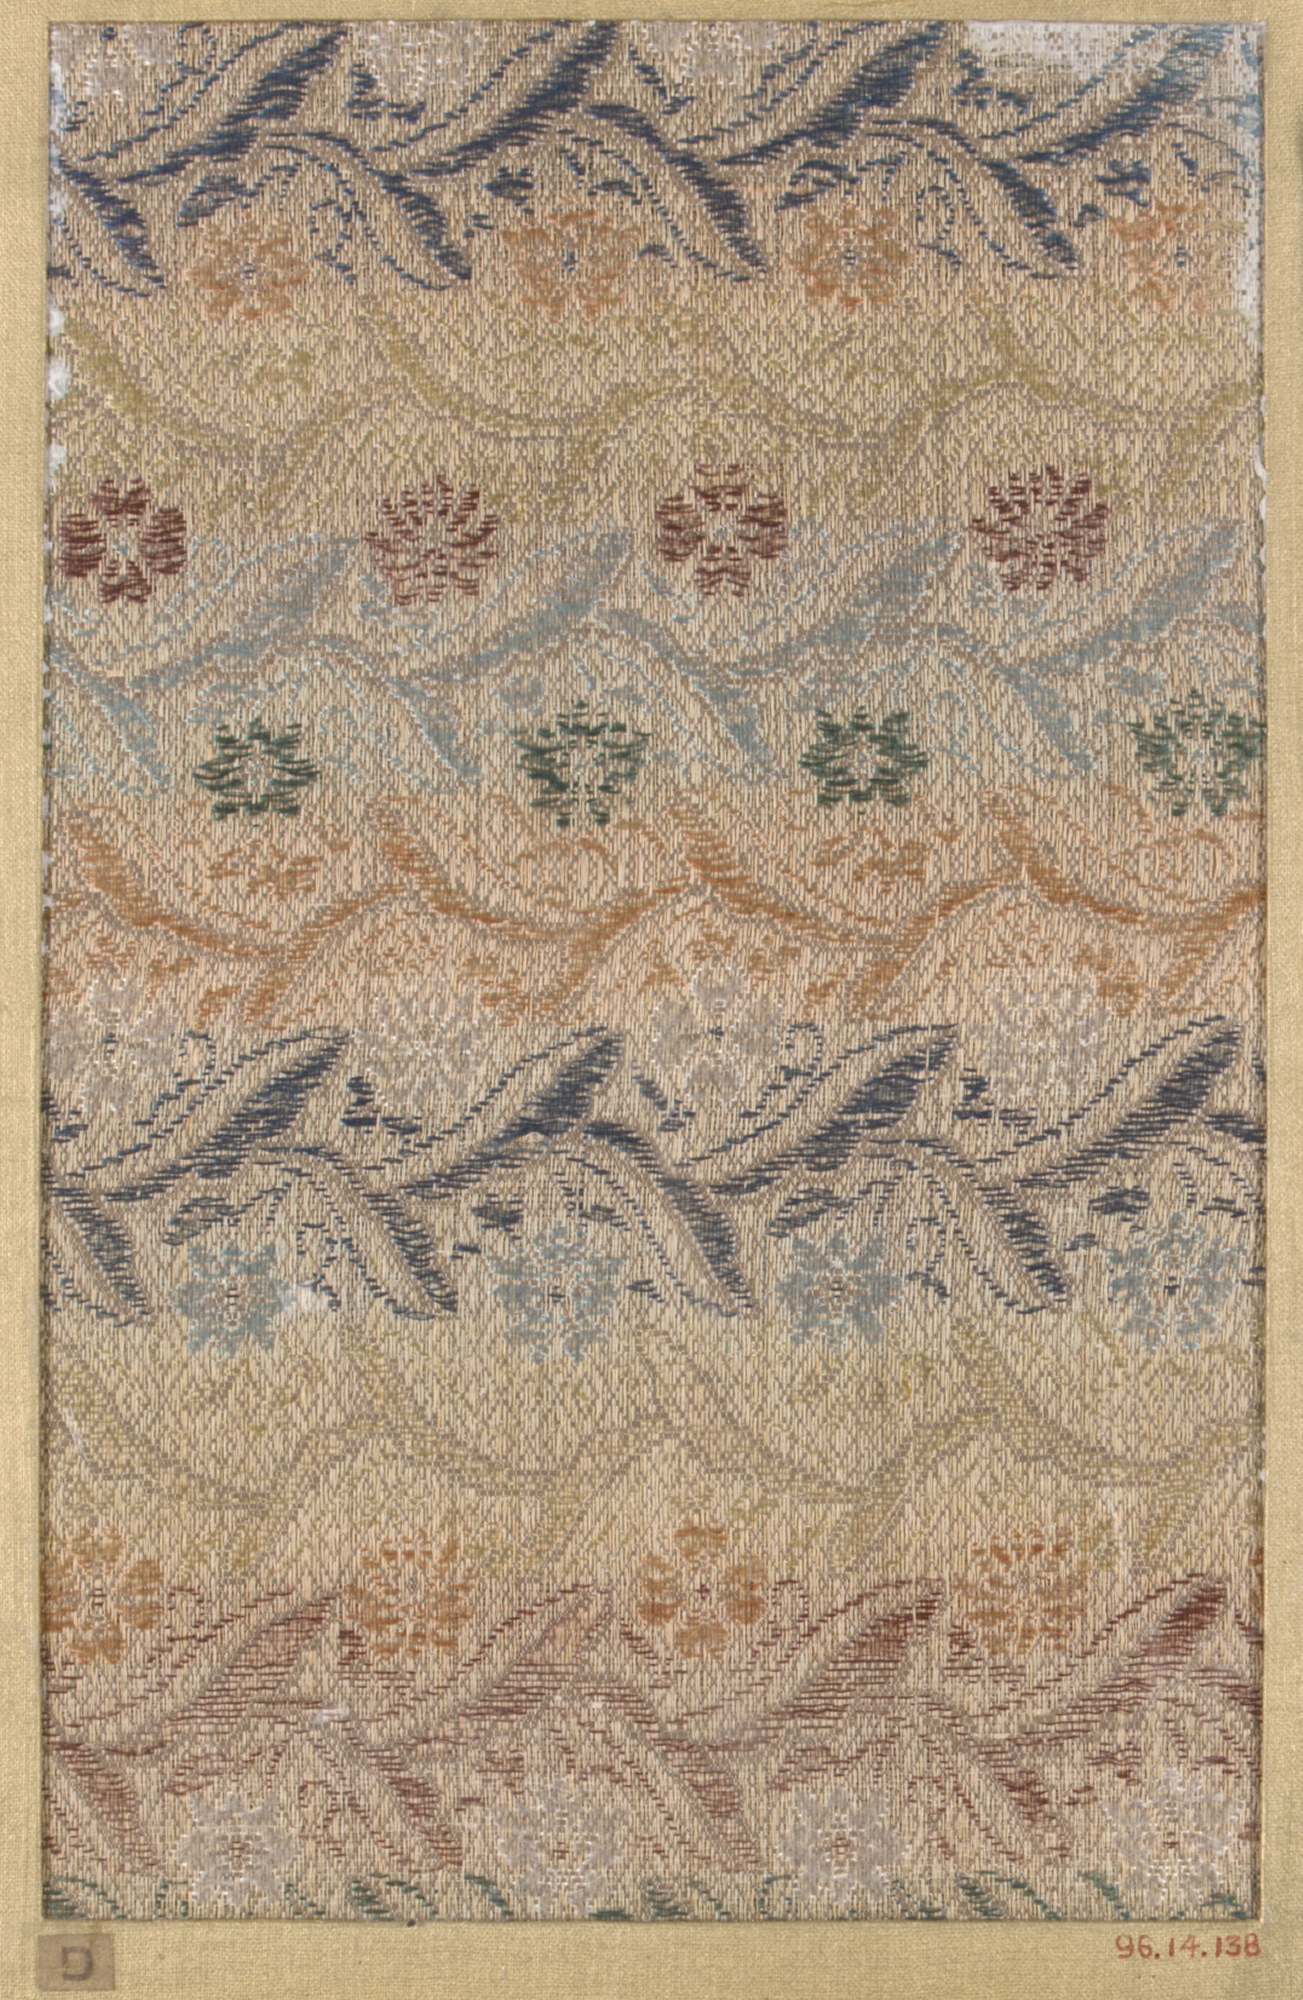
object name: piece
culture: japanese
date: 1701-1900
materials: silk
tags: flowers